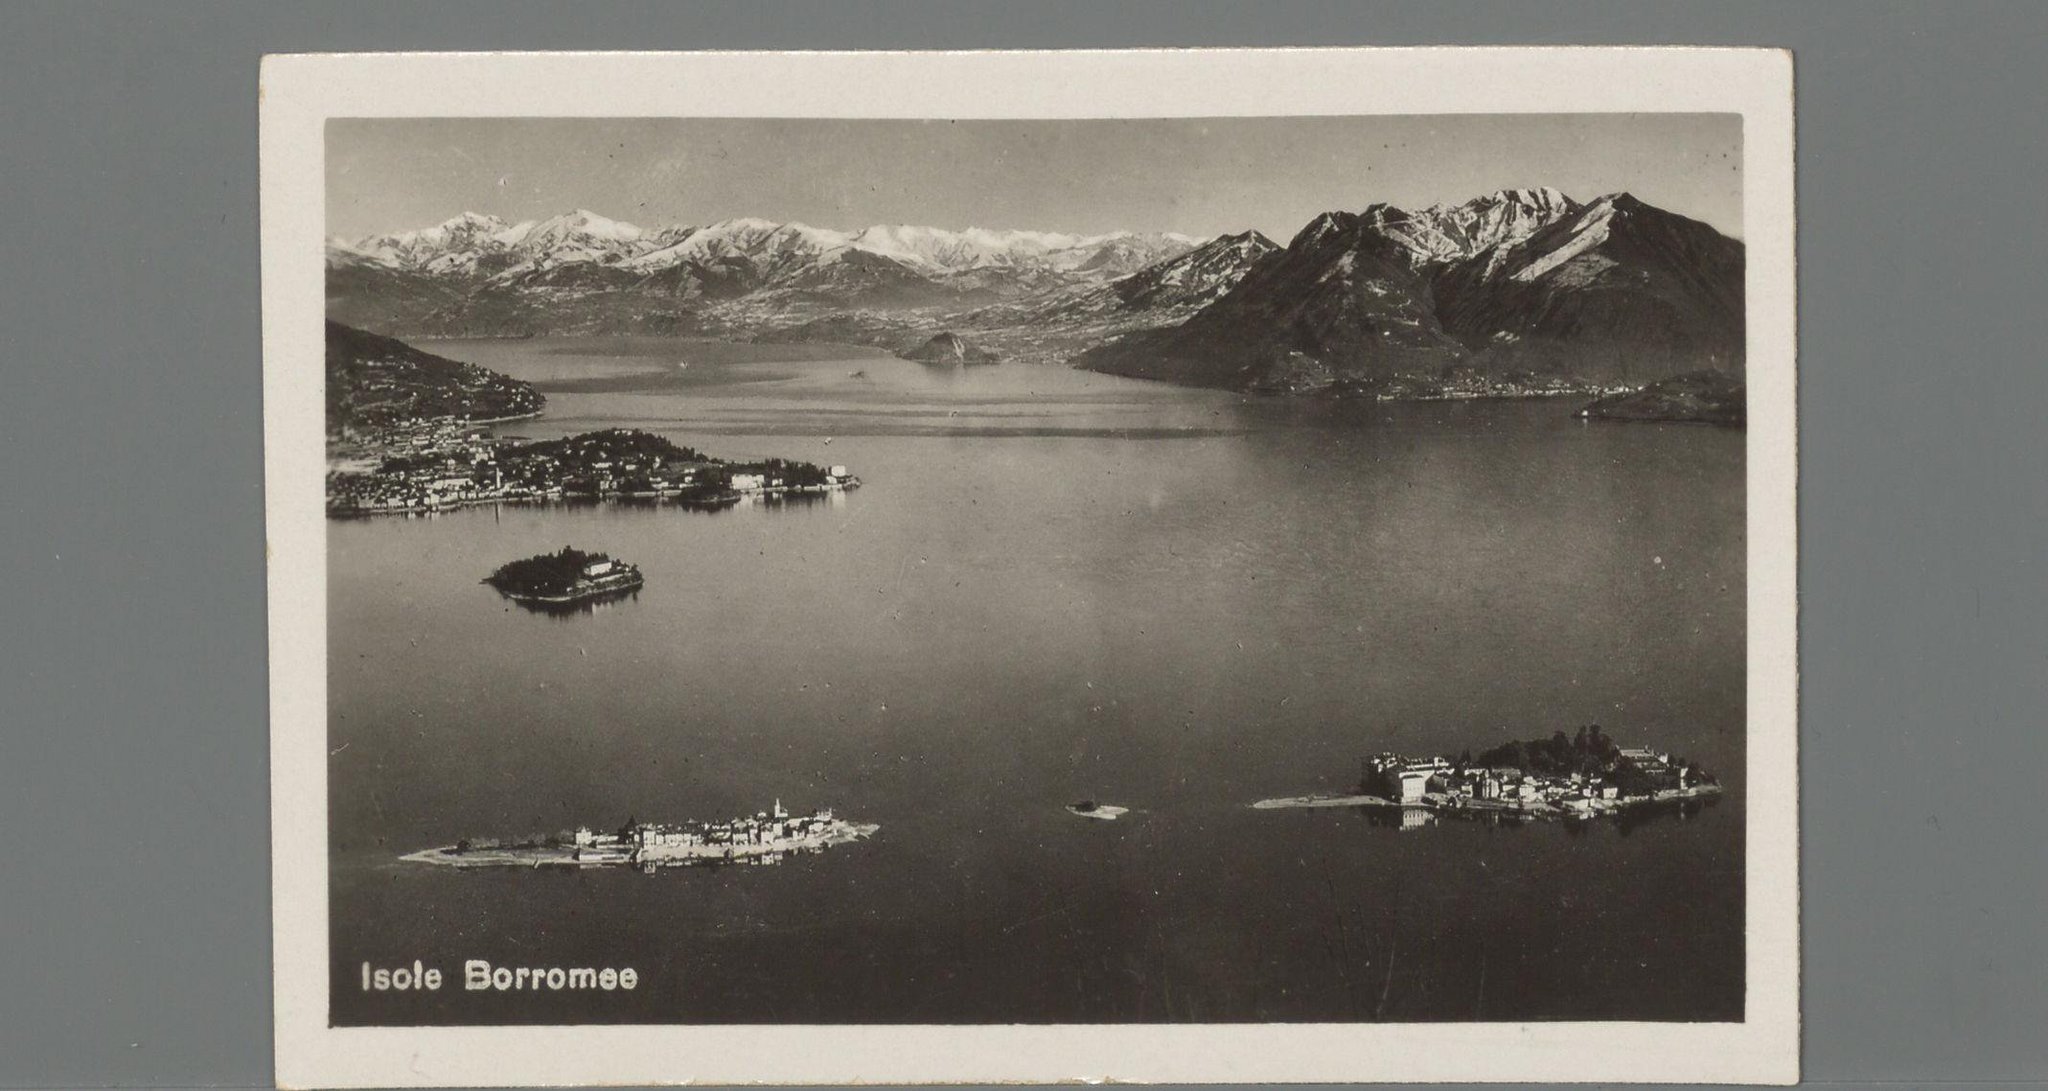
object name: photograph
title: Pallanza ed Isole Borromee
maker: Anonymous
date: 1904-1935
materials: photographic support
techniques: photography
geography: como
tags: lake, mountains